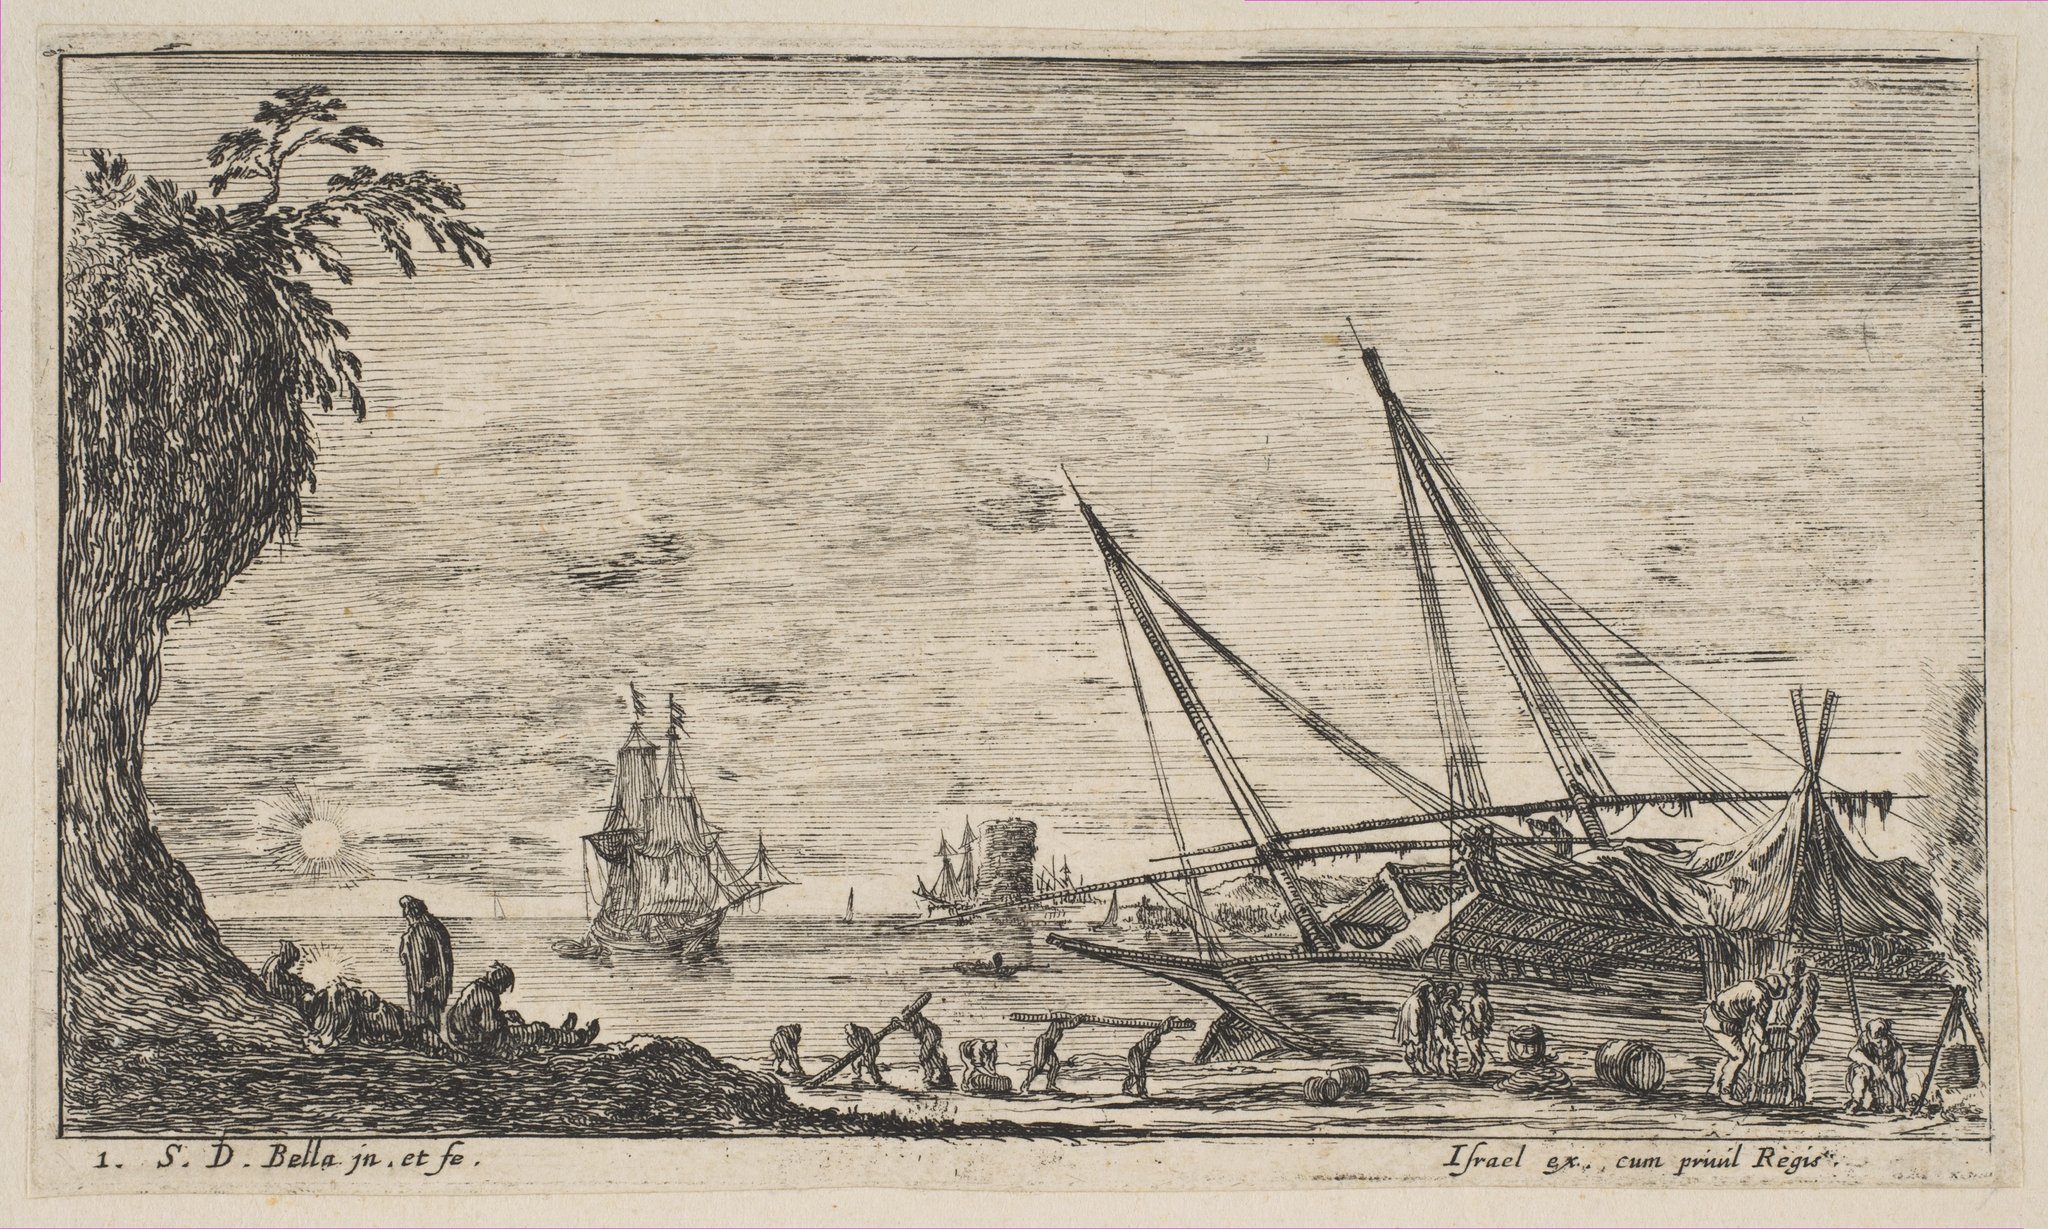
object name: print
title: Plate 1: seaport with ships, from "Seascapes" (Paysages maritimes)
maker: stefano della bella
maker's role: artist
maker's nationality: italian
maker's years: 1610-1664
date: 1644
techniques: etching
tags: seascapes,ships